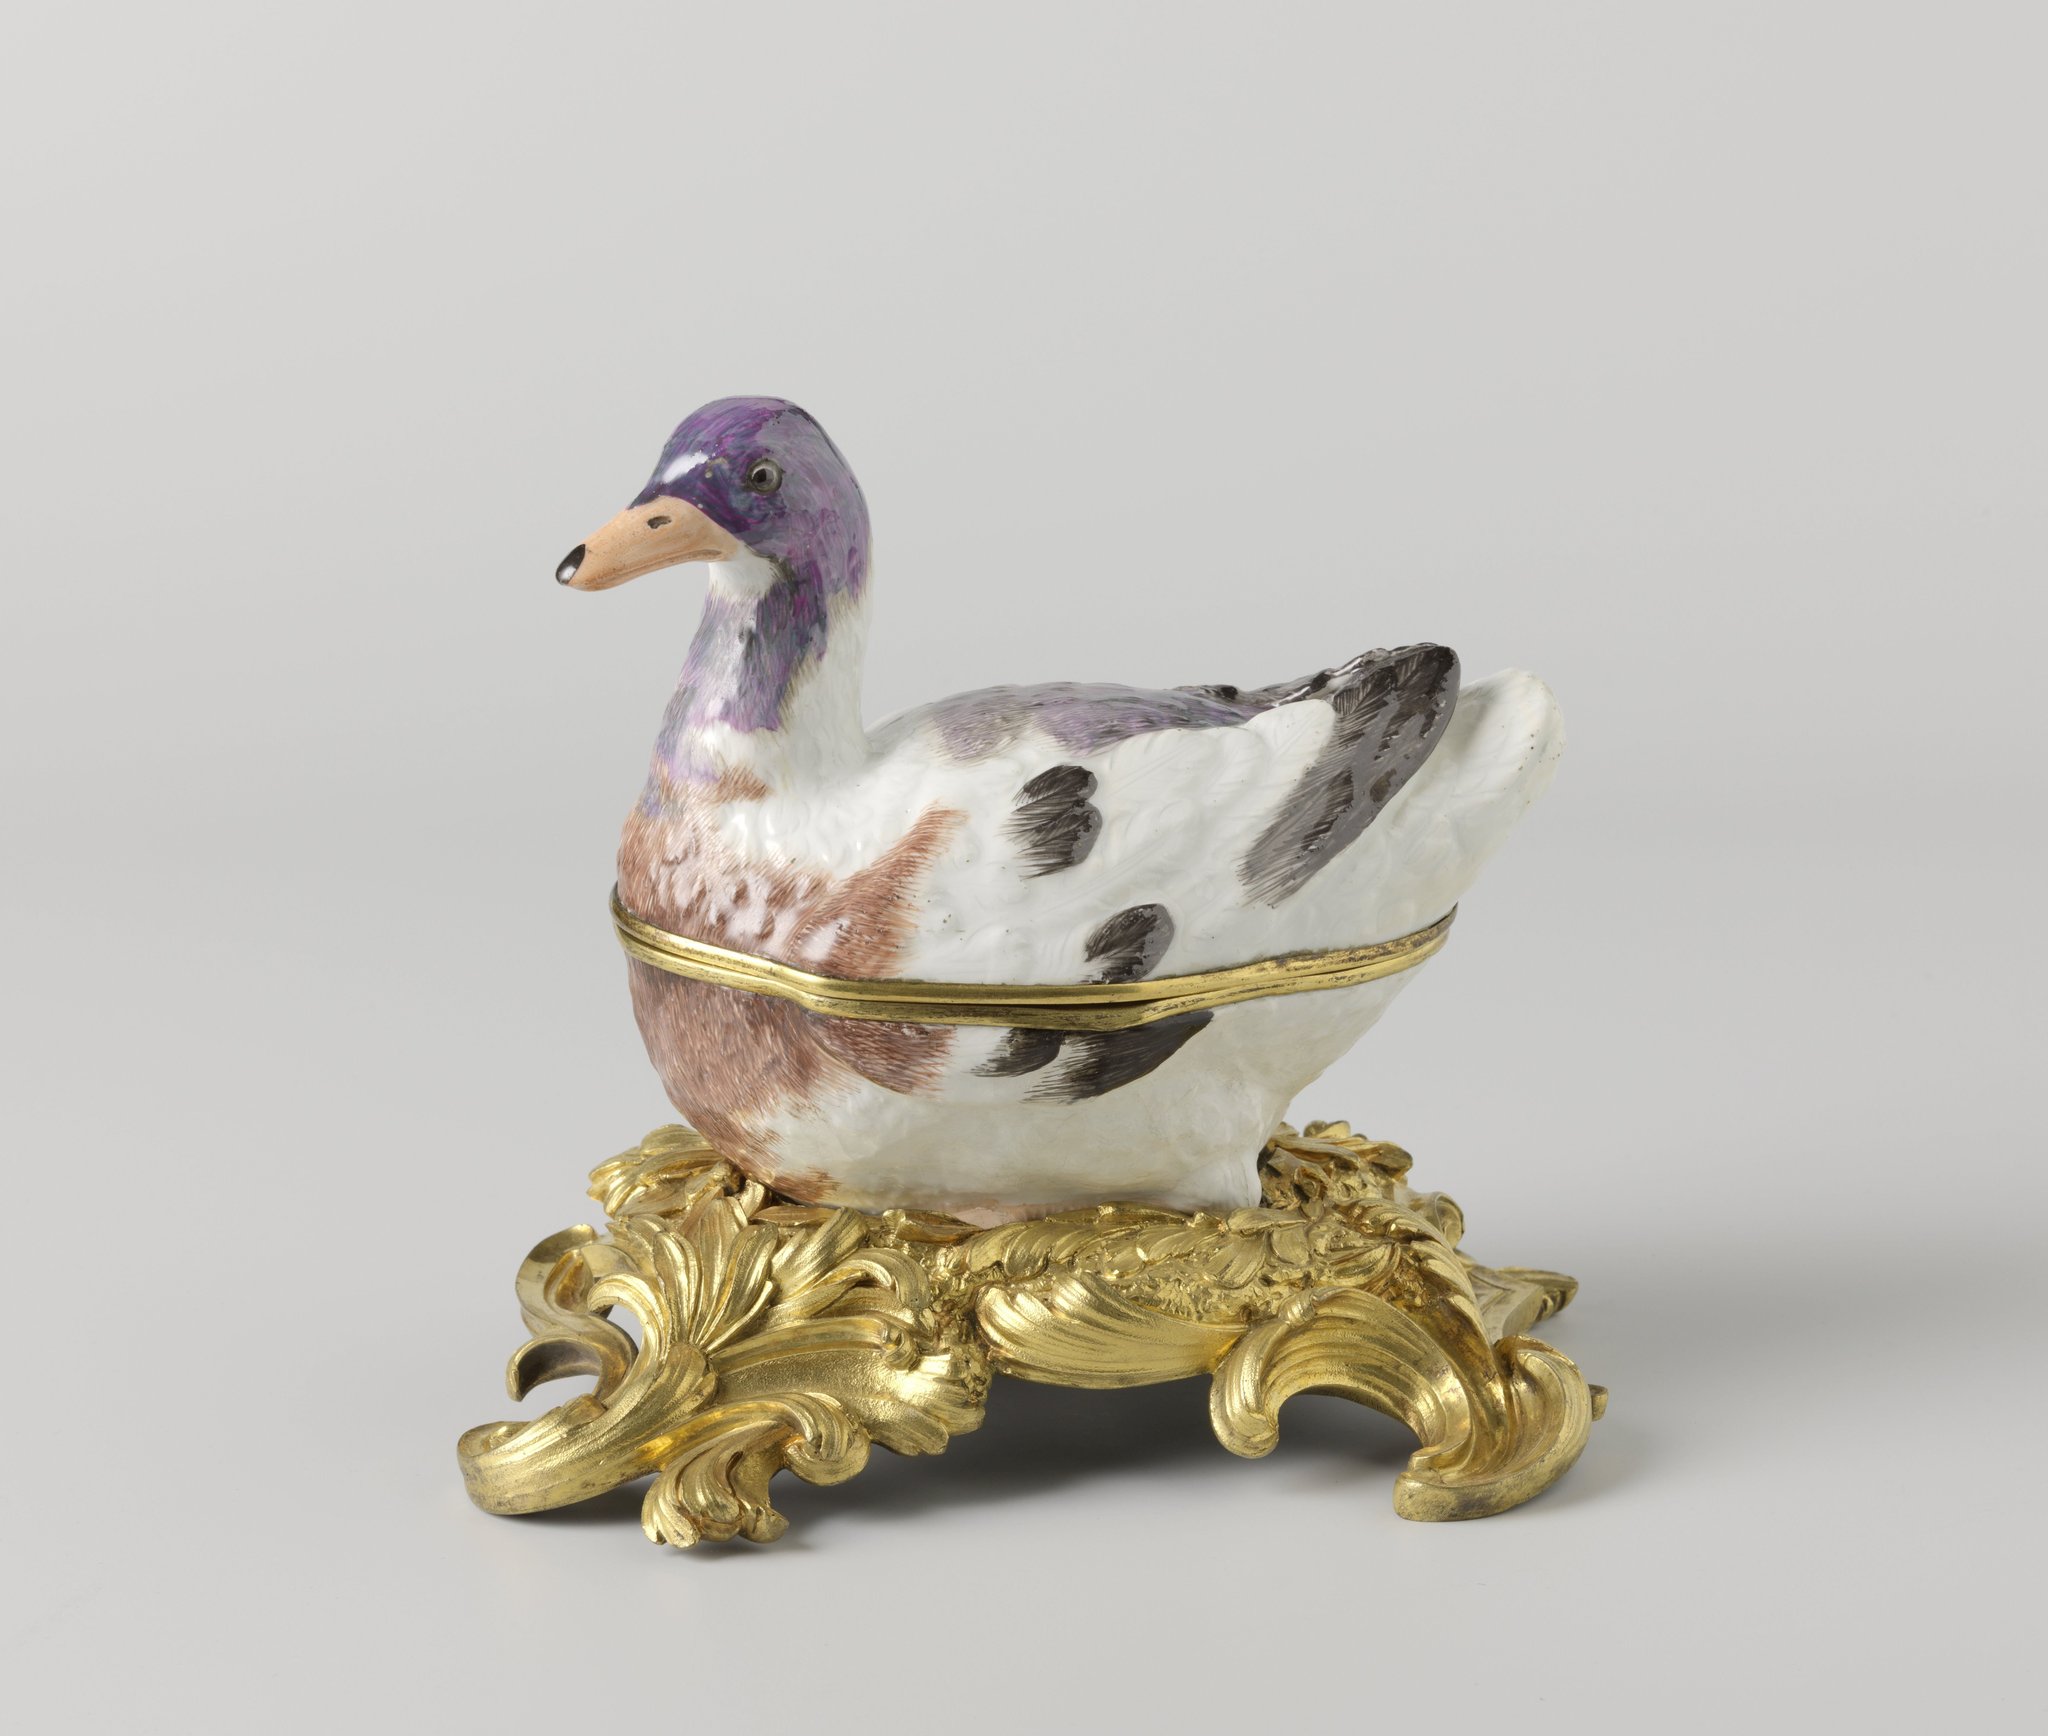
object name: box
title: Doos in de vorm van een eend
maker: johann joachim kändler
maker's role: designer, sculptor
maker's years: 1706-1775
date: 1740-1748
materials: bronze, porcelain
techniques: gilding, painted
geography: meissen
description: Doos van beschilderd porselein, buik van de eend, met goudkleurige rand. De eend is gedeeltelijk beschilderd in blauw, groen, bruingrijs en zwart. De doos is ongemerkt.